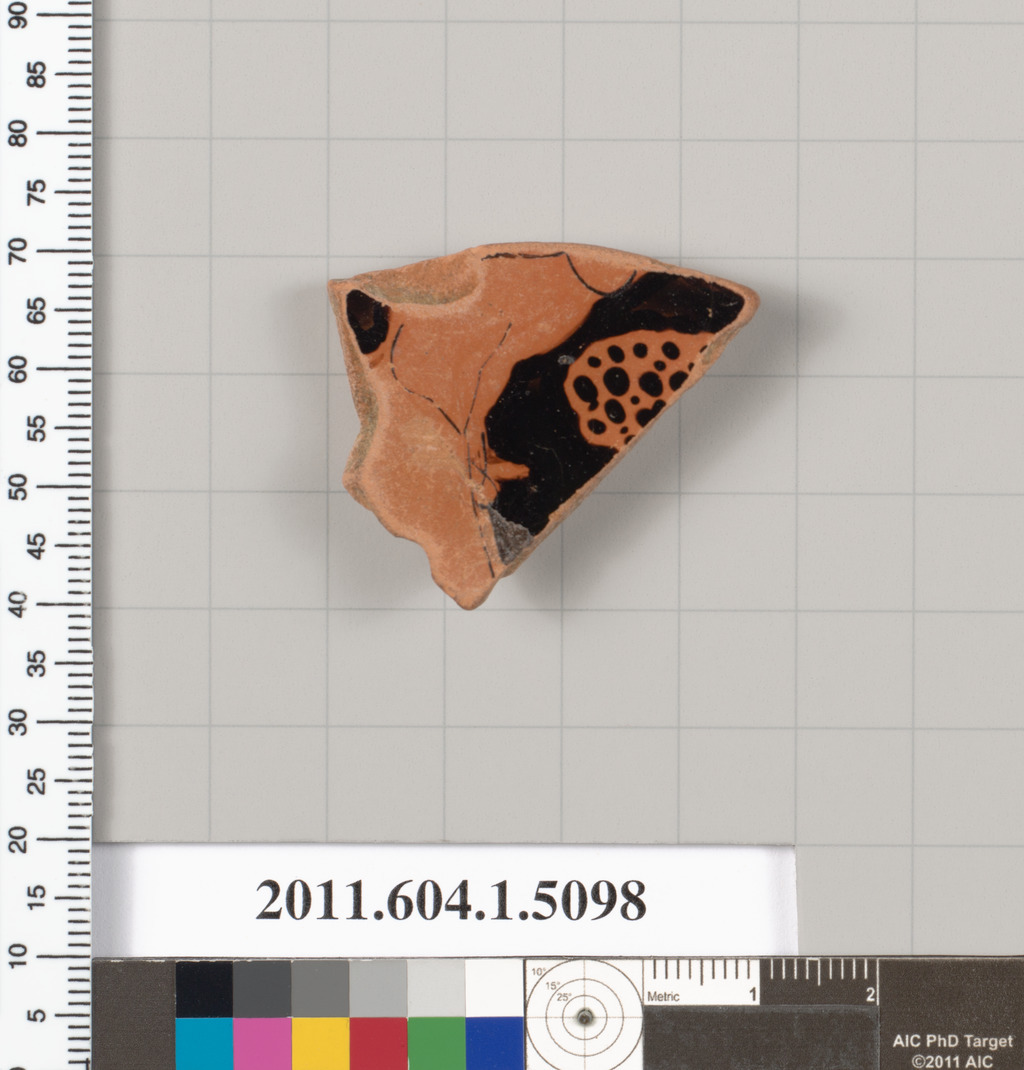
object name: kylix fragment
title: Terracotta fragment of a kylix (drinking cup)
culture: greek, attic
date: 480-470 BCE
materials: terracotta